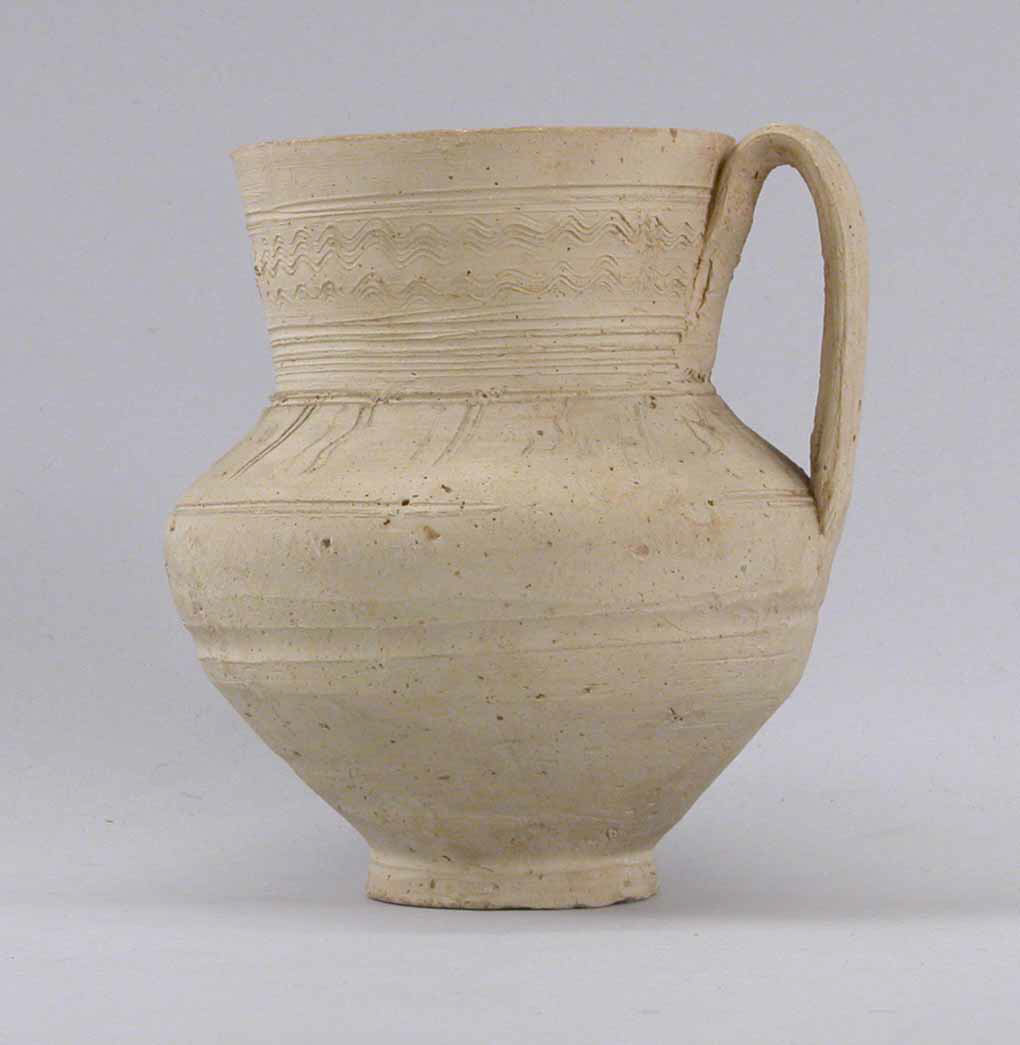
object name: ewer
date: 901-1100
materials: earthenware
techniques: incising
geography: iran